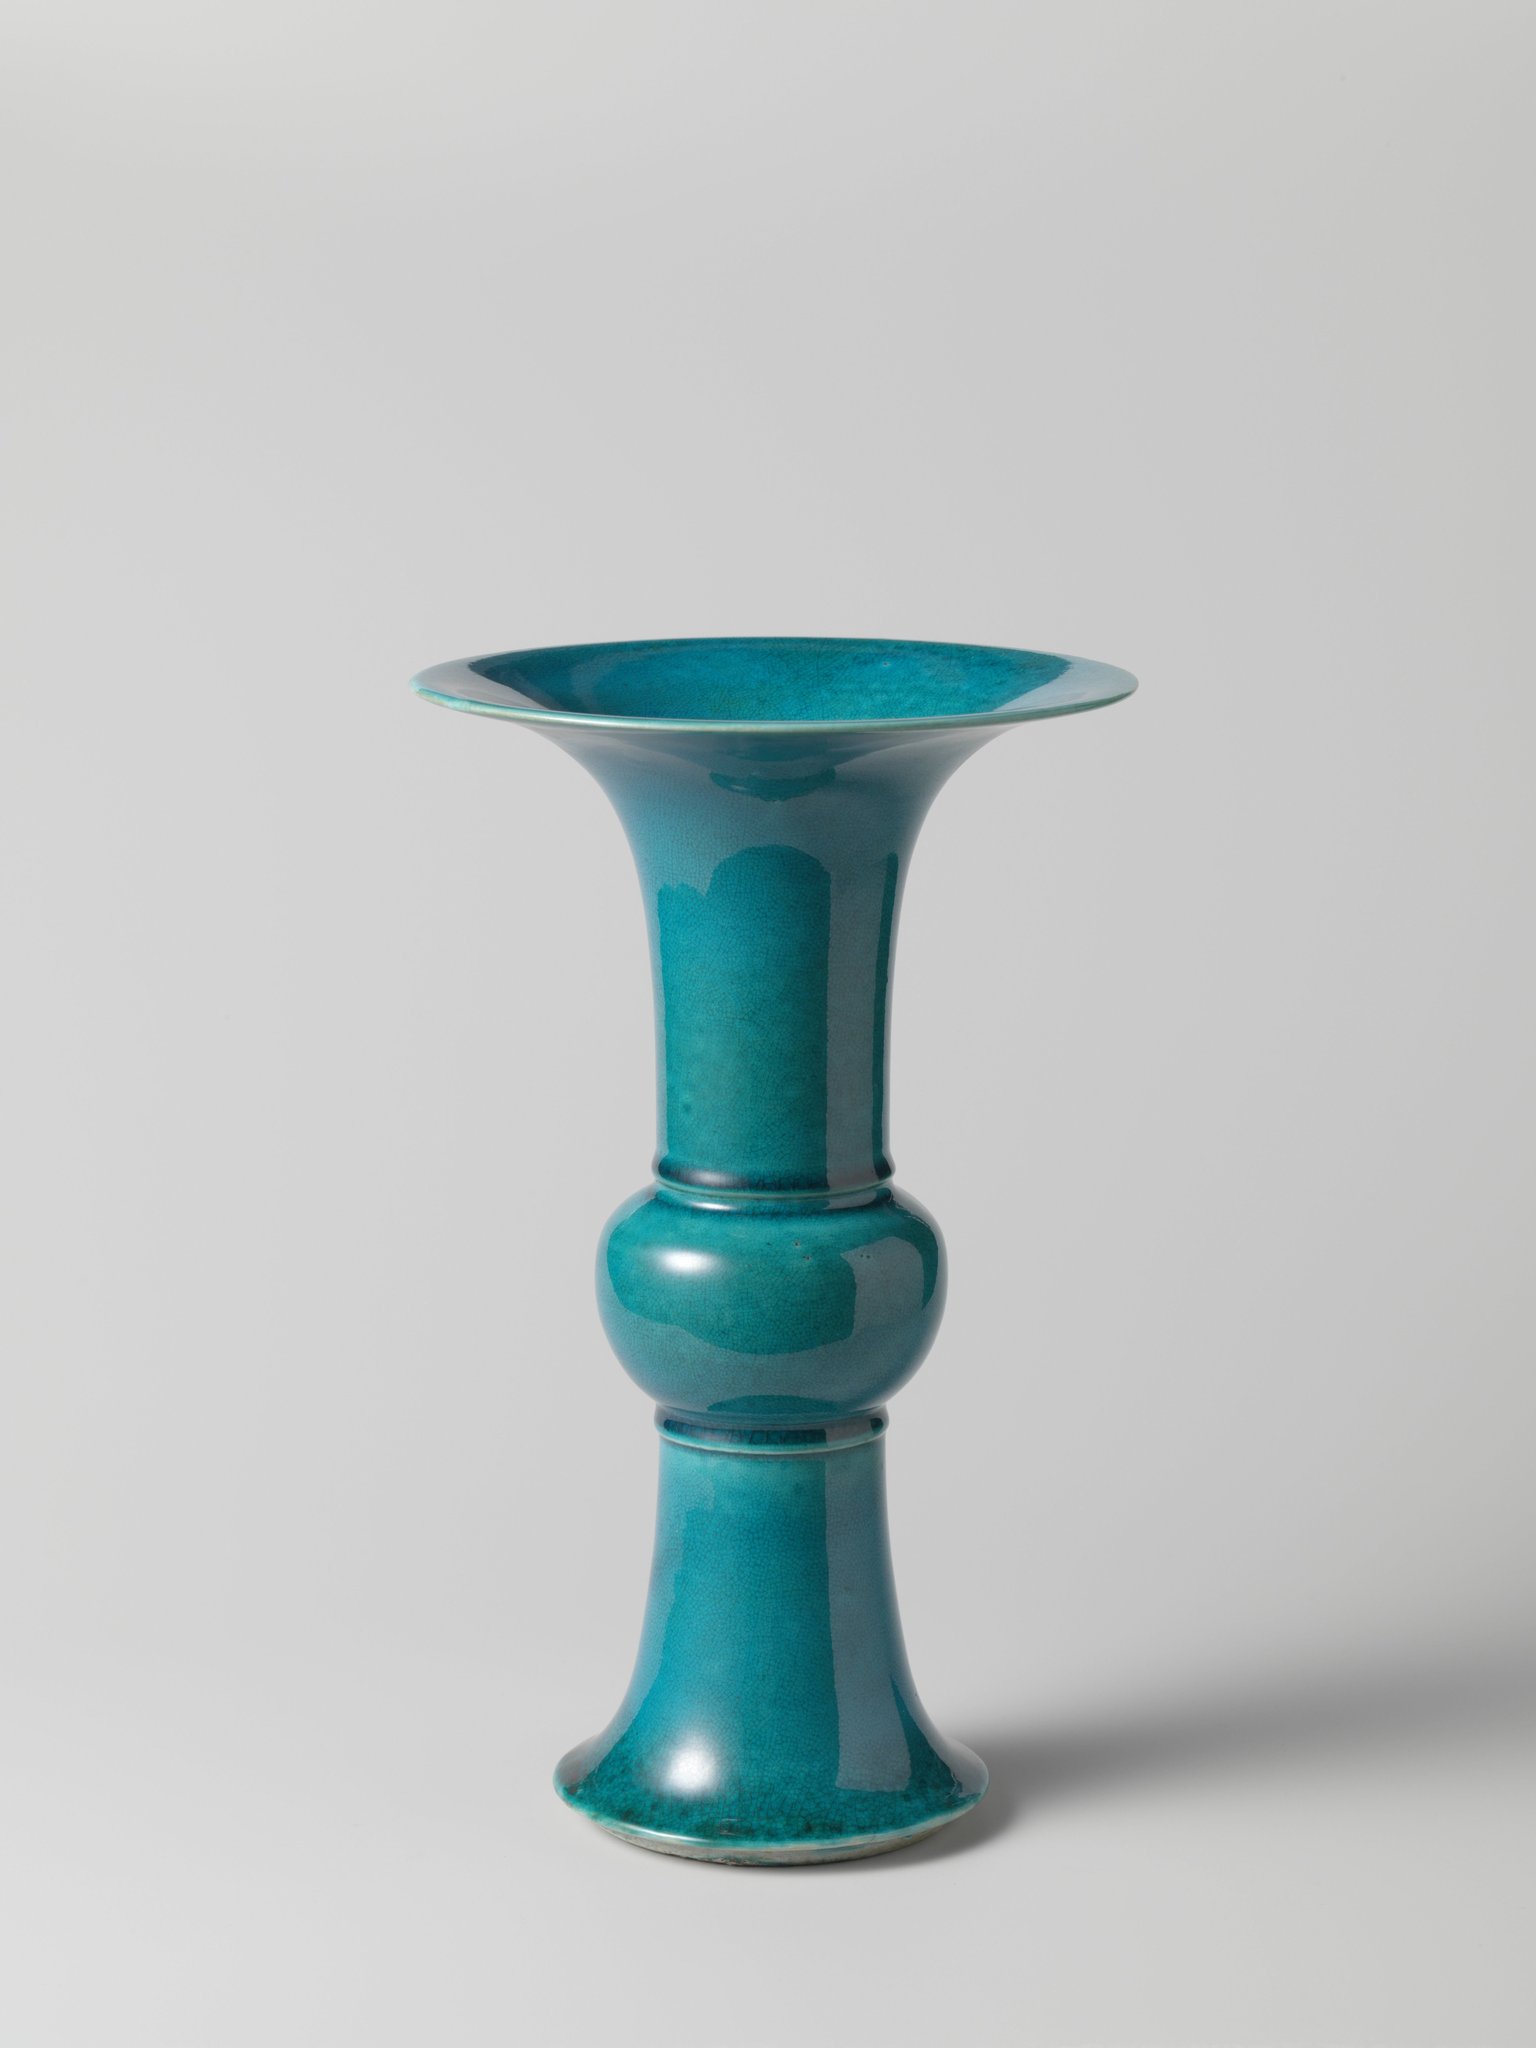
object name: vase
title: Gu-shaped vase, trumpet-shaped mouth and a bulb in the body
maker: Anonymous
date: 1750-1799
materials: glaze, porcelain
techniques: forming, turning, vitrification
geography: china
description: Gu-vormige vaas van porselein, bedekt met een licht gecraqueleerd, monochroom turquoise glazuur. De vaas heeft een bolvormige verdikking, spreidende voet op voetring en een trompetvormige mond. Monochromen.